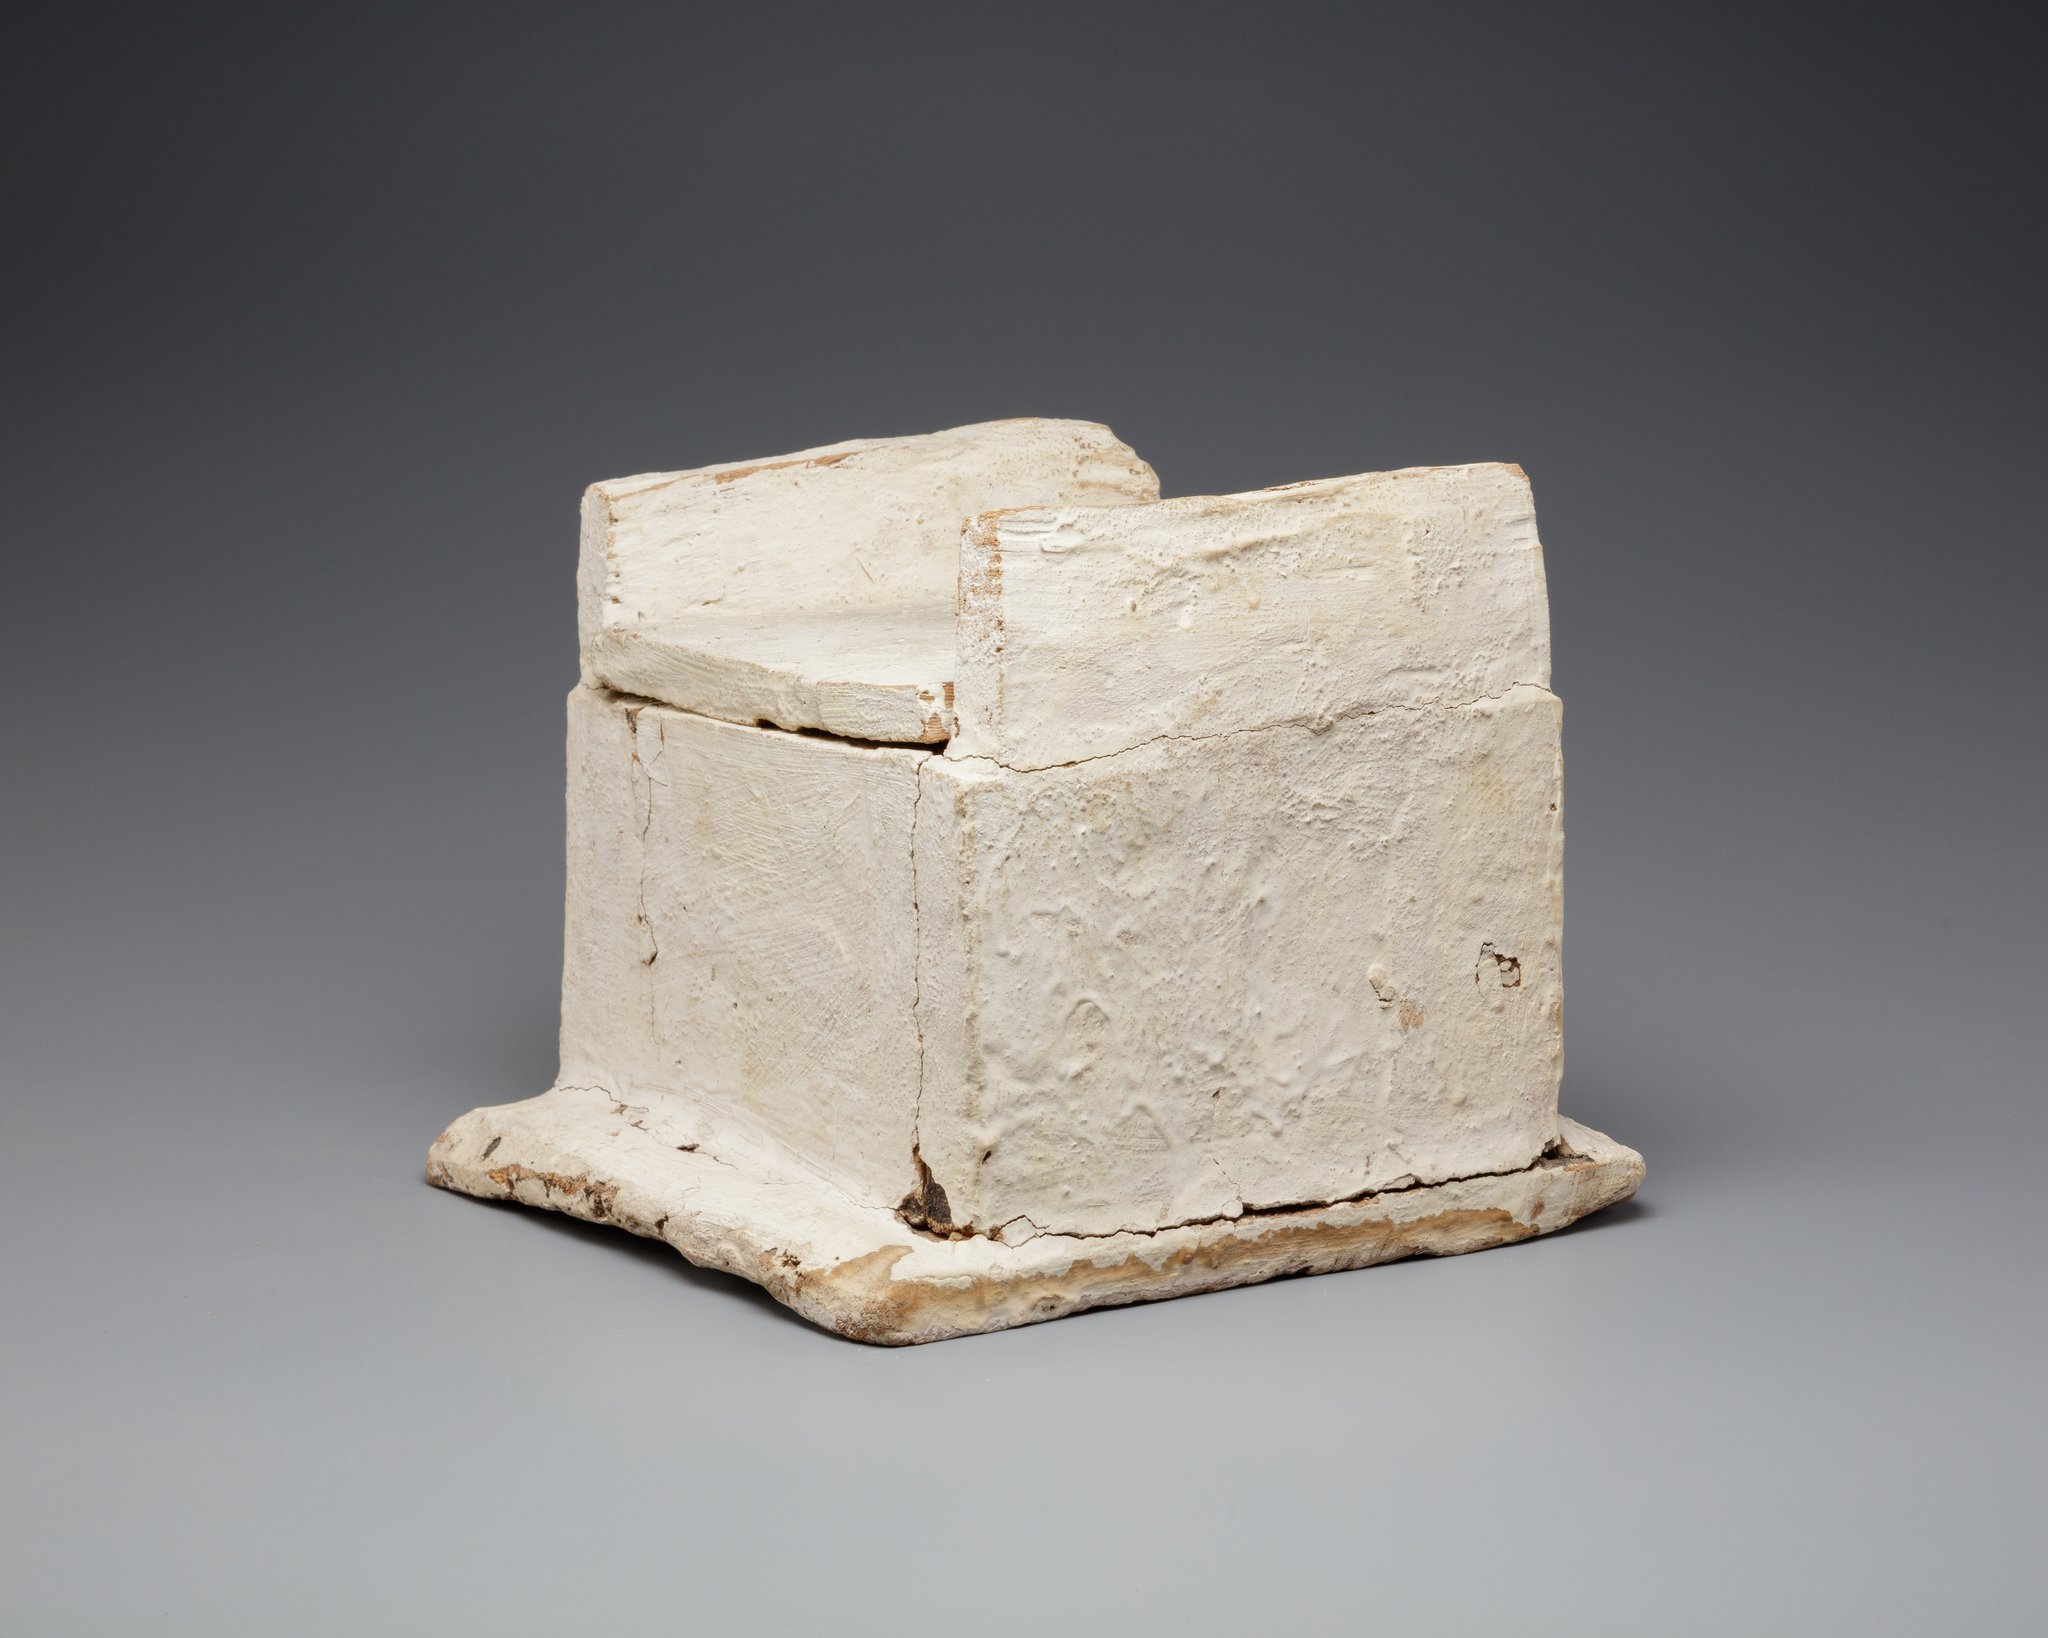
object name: shabti box, nauny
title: Shabti Box of Nauny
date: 1050 BCE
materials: paint, plaster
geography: egypt